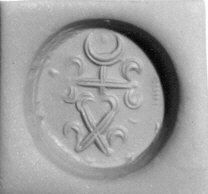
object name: stamp seal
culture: sasanian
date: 201-700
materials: stone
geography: iran or mesopotamia